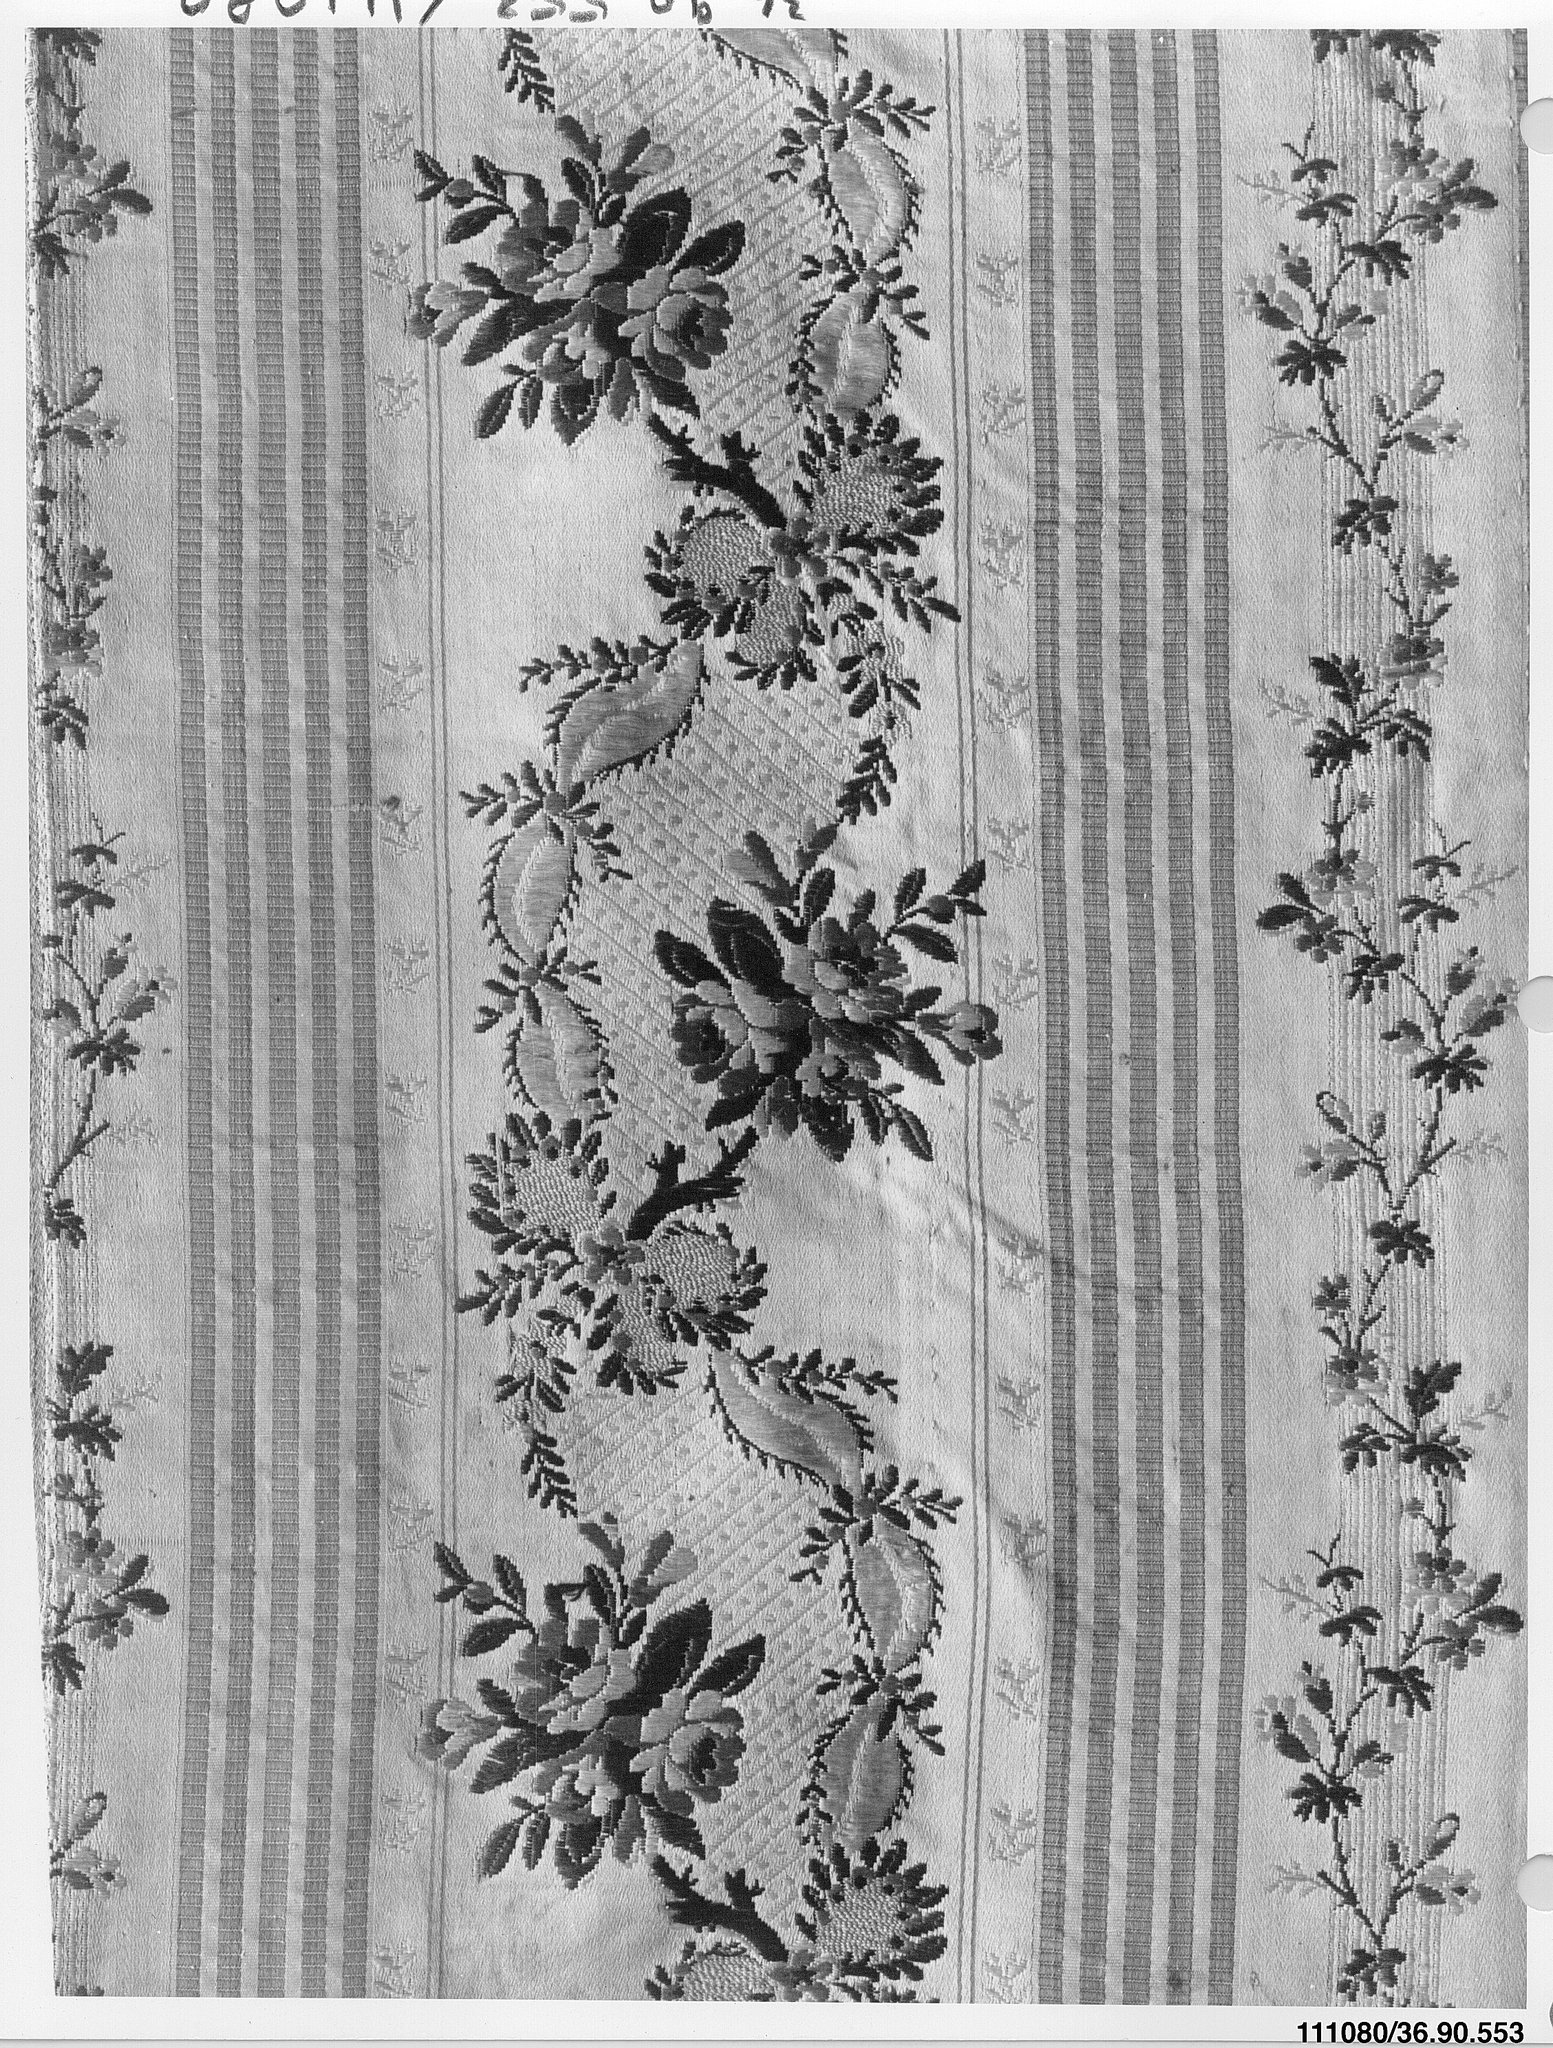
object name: piece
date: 1767-1800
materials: silk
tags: flowers